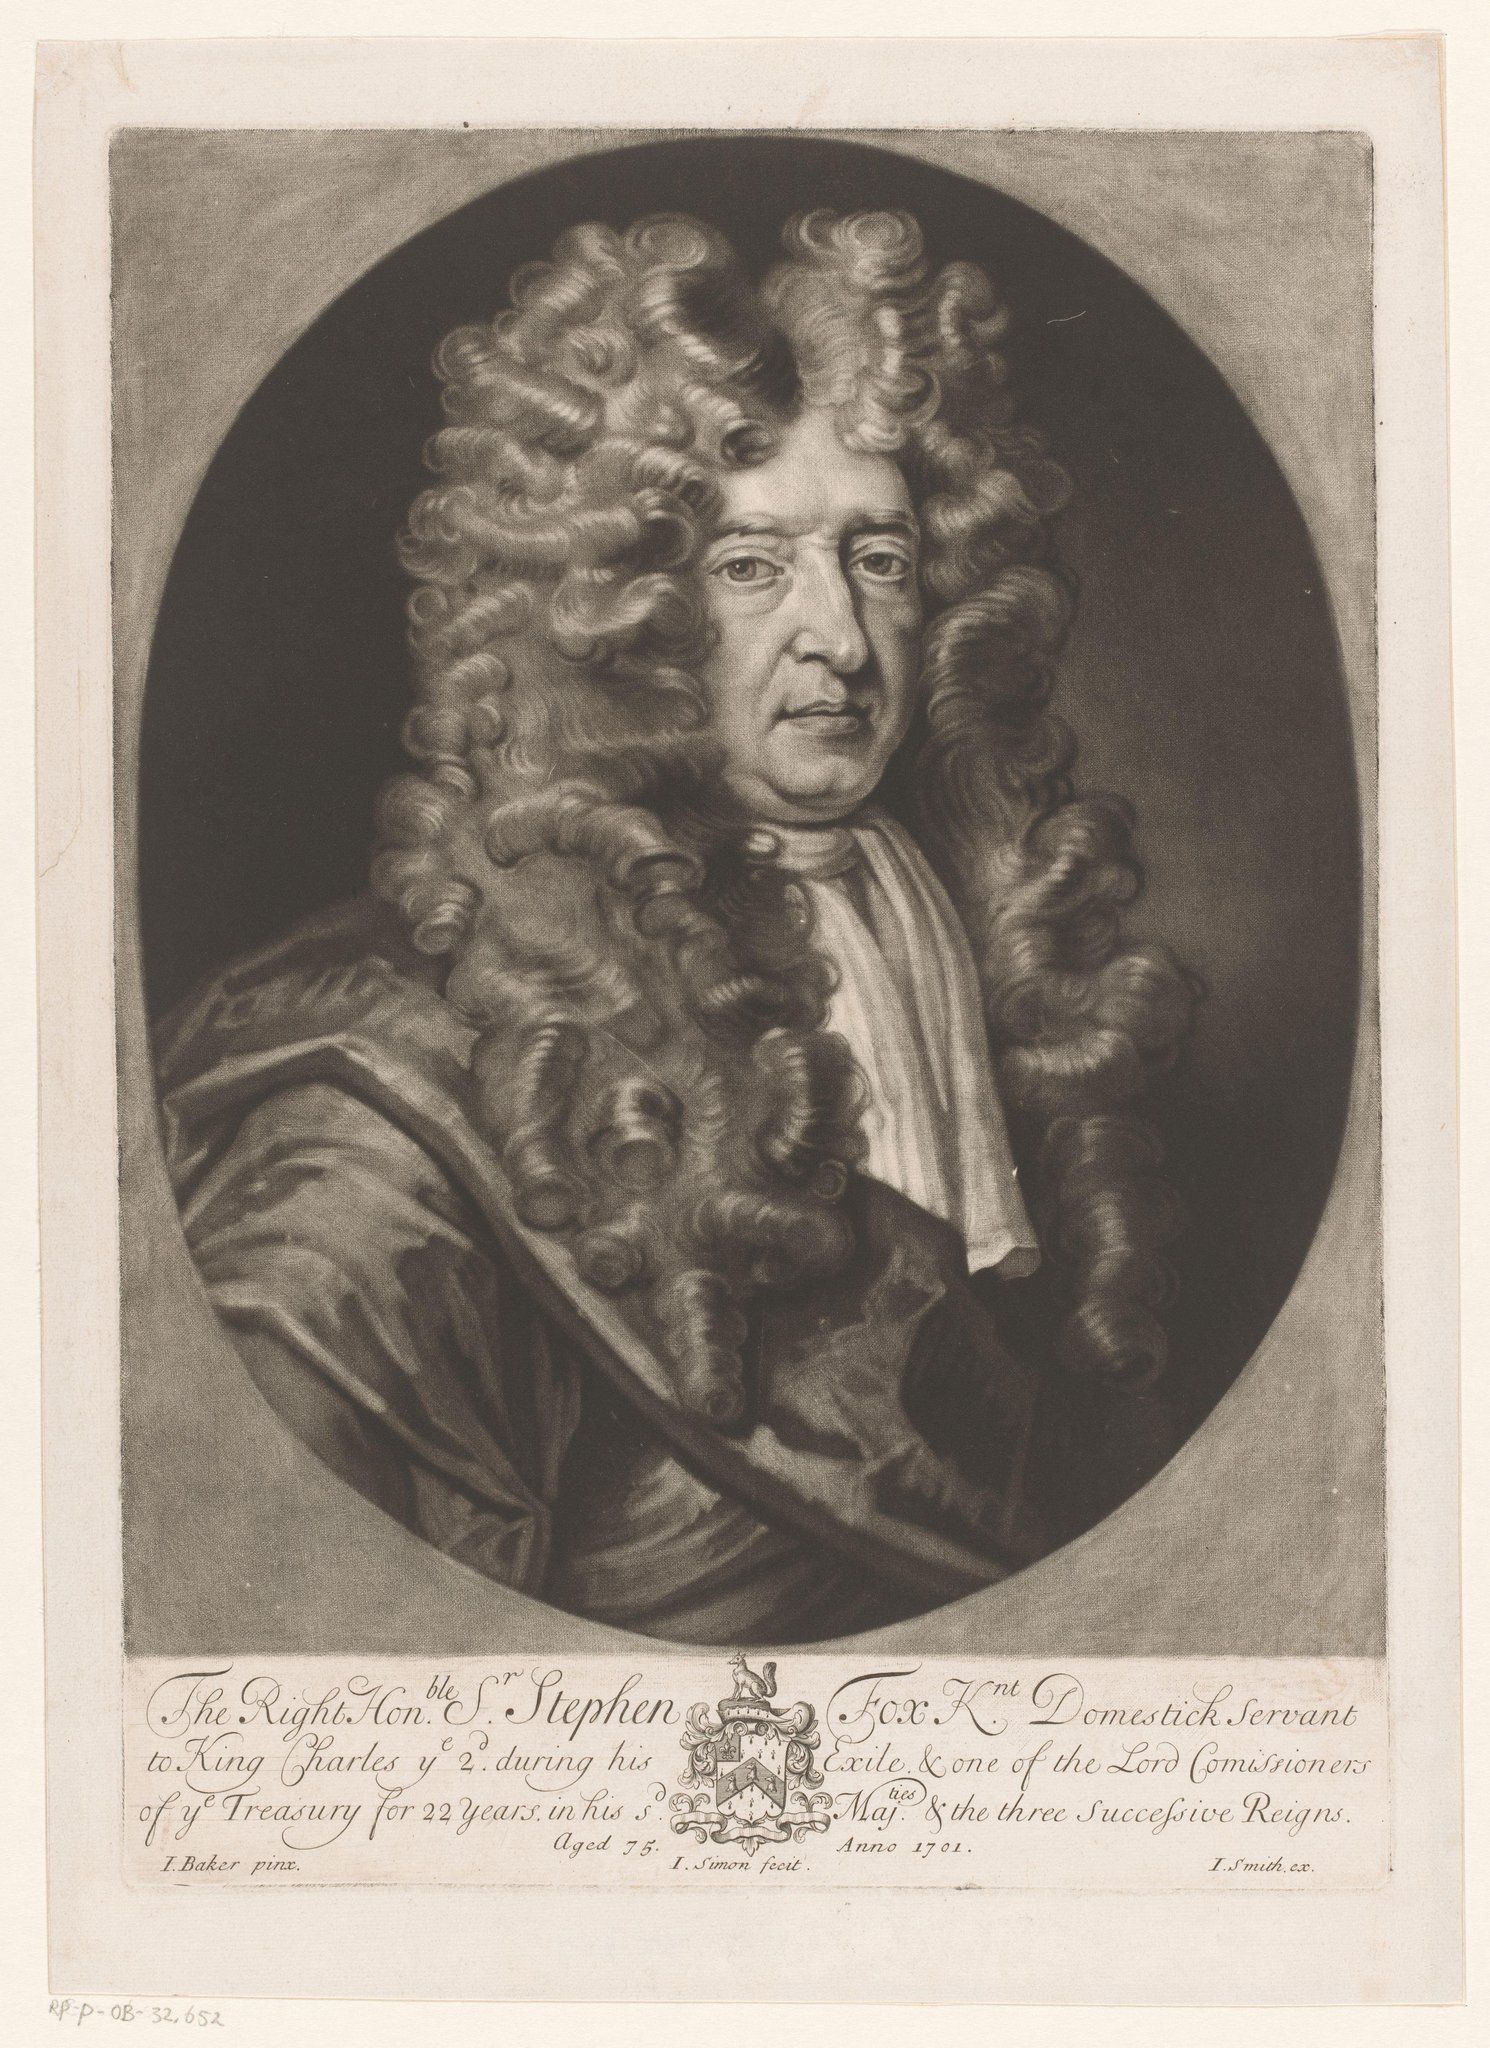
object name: print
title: Portret van Stephen Fox op 75-jarige leeftijd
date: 1701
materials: paper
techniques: etching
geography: london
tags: historical persons, politician, e.g. party leader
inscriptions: collector's mark: Lugt 240